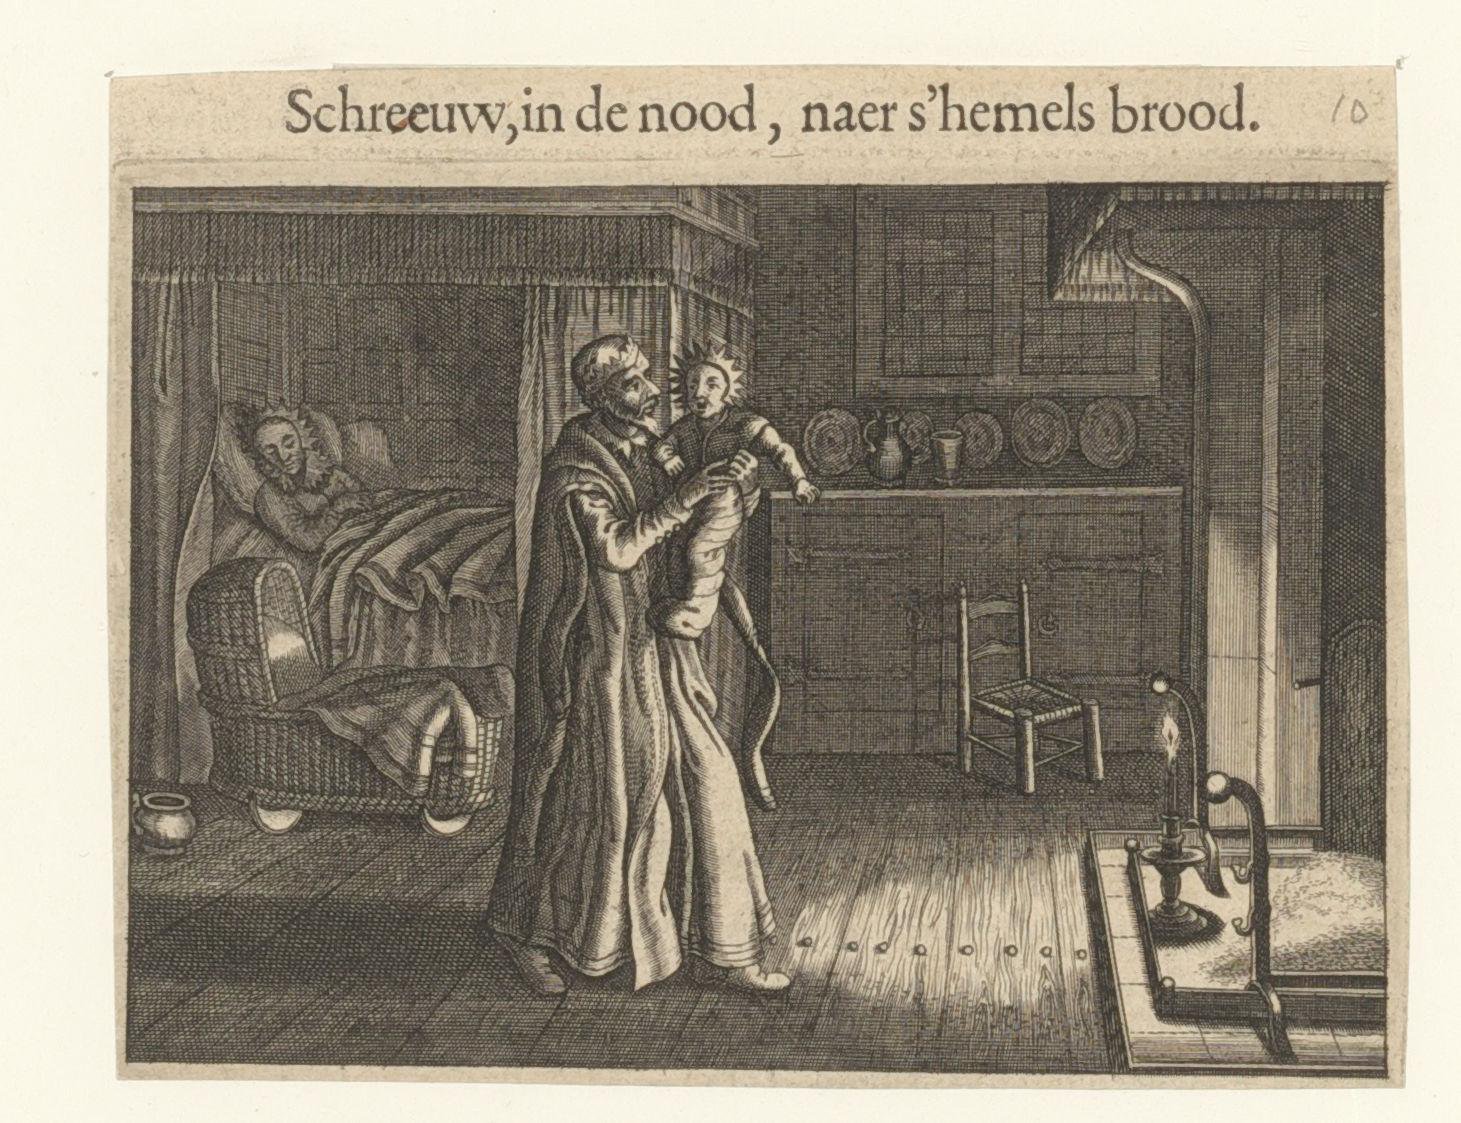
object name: print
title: Schreeuw, in de nood, naer s'hemels brood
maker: Anonymous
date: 1624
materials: paper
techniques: engraving, letterpress printing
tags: adult woman, faith, 'fides'; 'fede', 'fede catholica', 'fede christiana', 'fede christiana catholica' (ripa) ~ one of the three theological virtues, (doctrine on) divine grace; 'gratia di dio', 'gratia divina' (ripa), bed with tester, proverbs, sayings, etc., sleeping in bed, cradle, crib, bedroom, father and child(ren), man and child(ren) (family group)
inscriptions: collector's mark: Lugt 1641, stamp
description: Embleem uit: Brune, Johan de. Zinne-werck, Voor-ghesyelt in Beelden, Ghedichten, ende breeder uyt-legginghen (...). Amsterdam: Evertsen Kloppenburch, 1624. Prent ook gebruikt in latere edities (1636 en 1661).